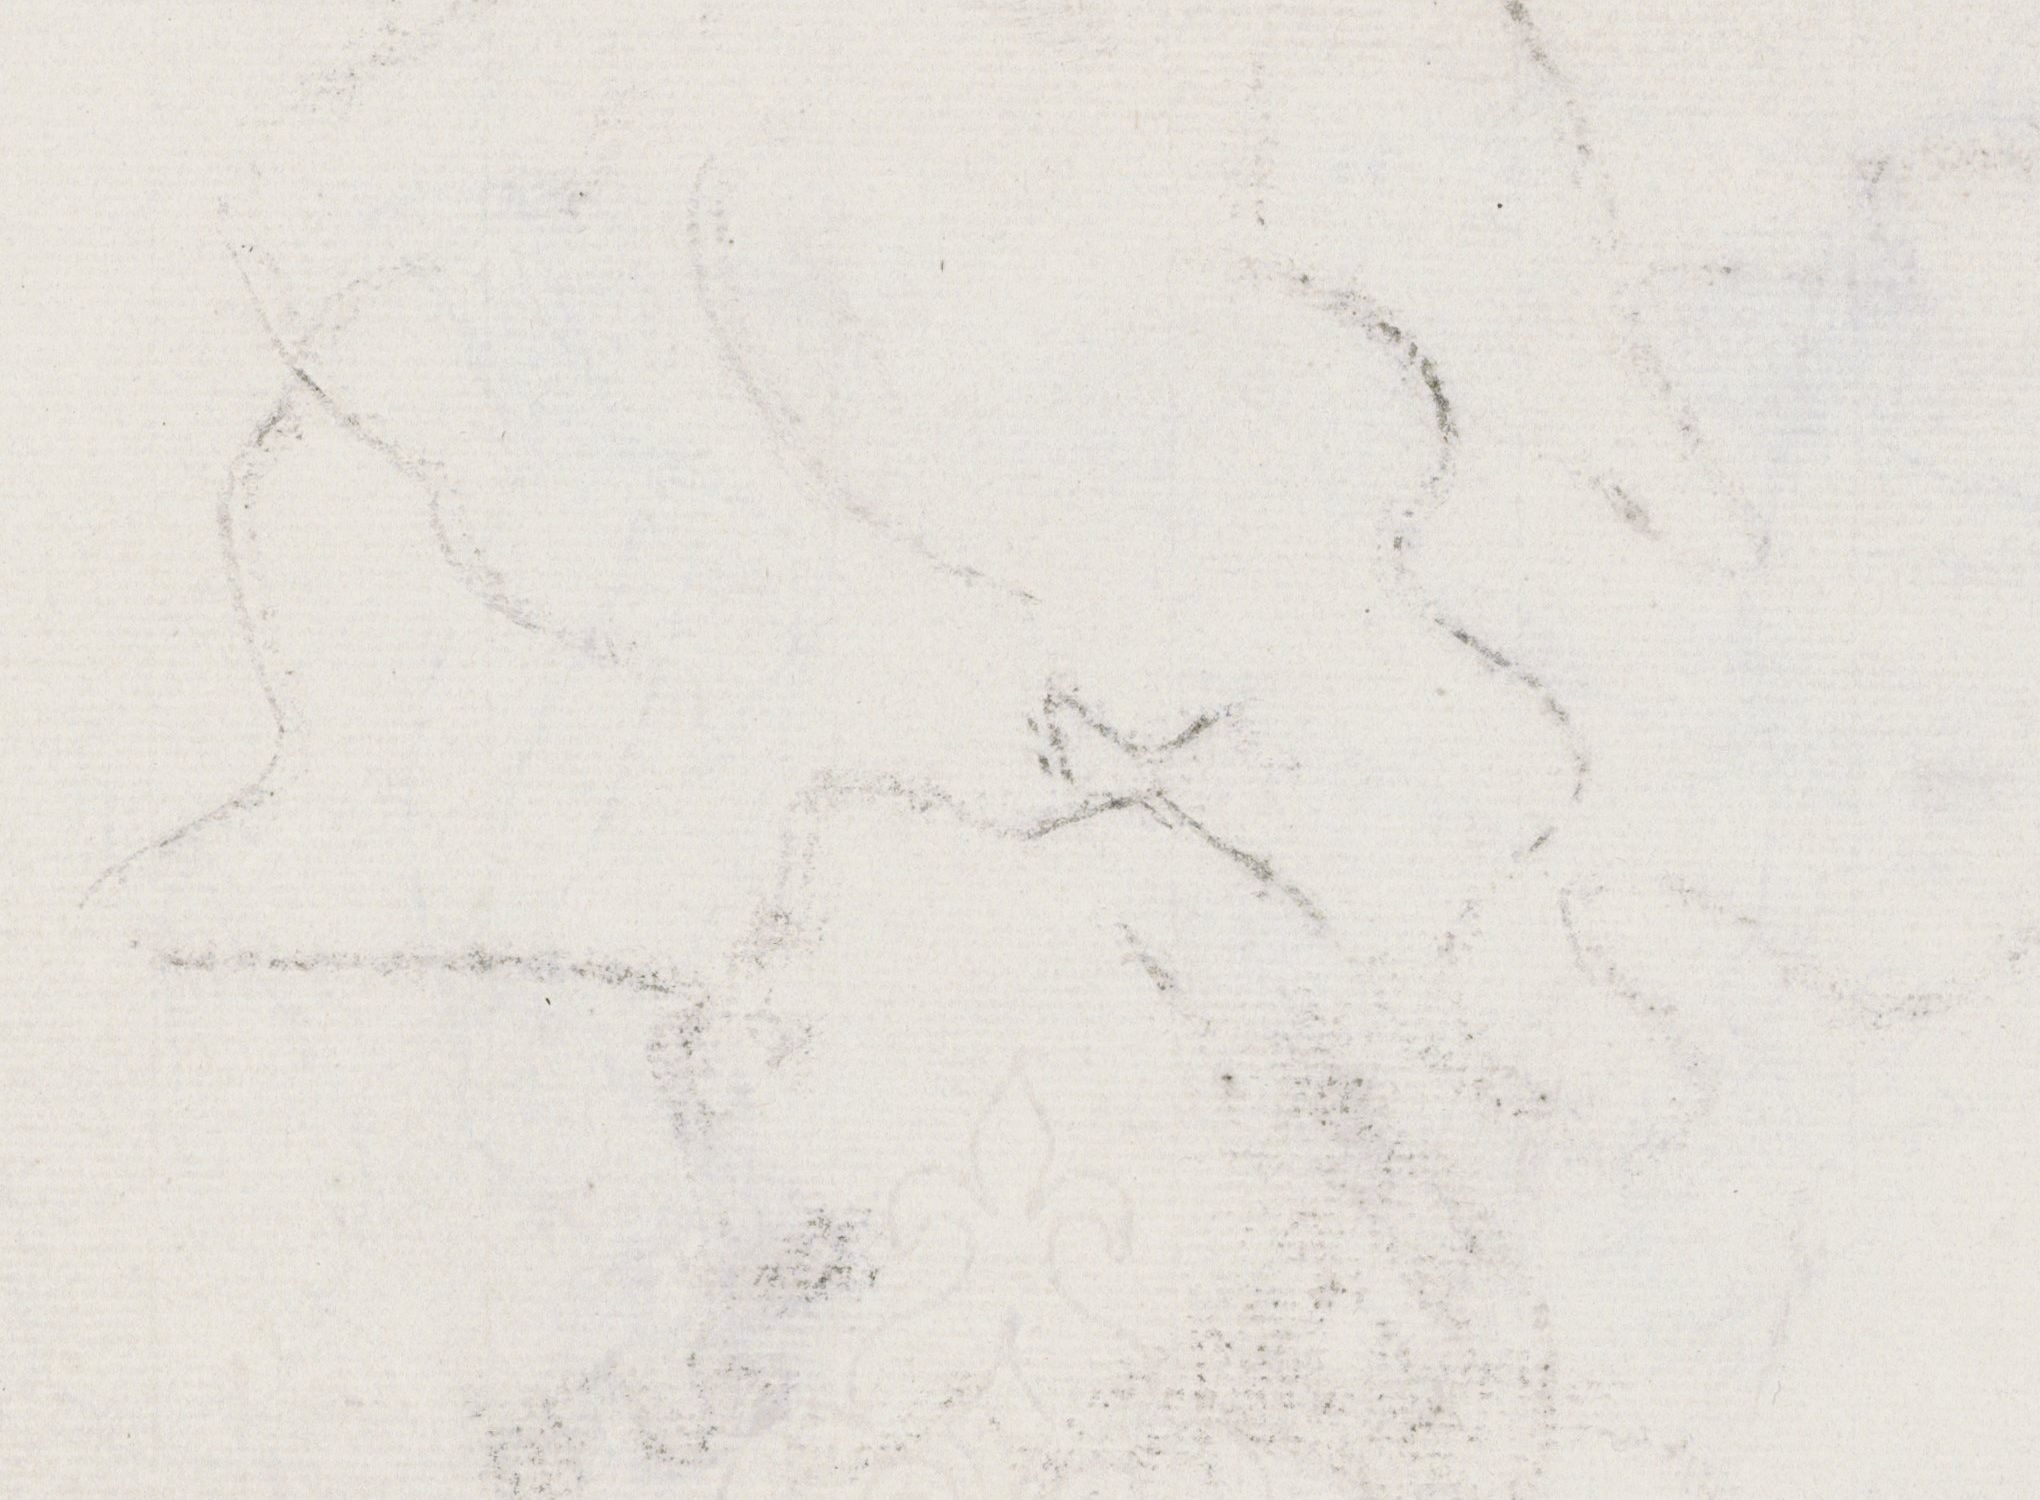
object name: sketchbook leaf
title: Abklatsch van de krijttekening op blad 17 verso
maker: isaac israels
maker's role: draughtsman, painter, print maker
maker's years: 1865-1934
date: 1875-1934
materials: paper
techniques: printmaking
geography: the hague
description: Blad 18 recto uit schetsboek XXI met 19 bladen.